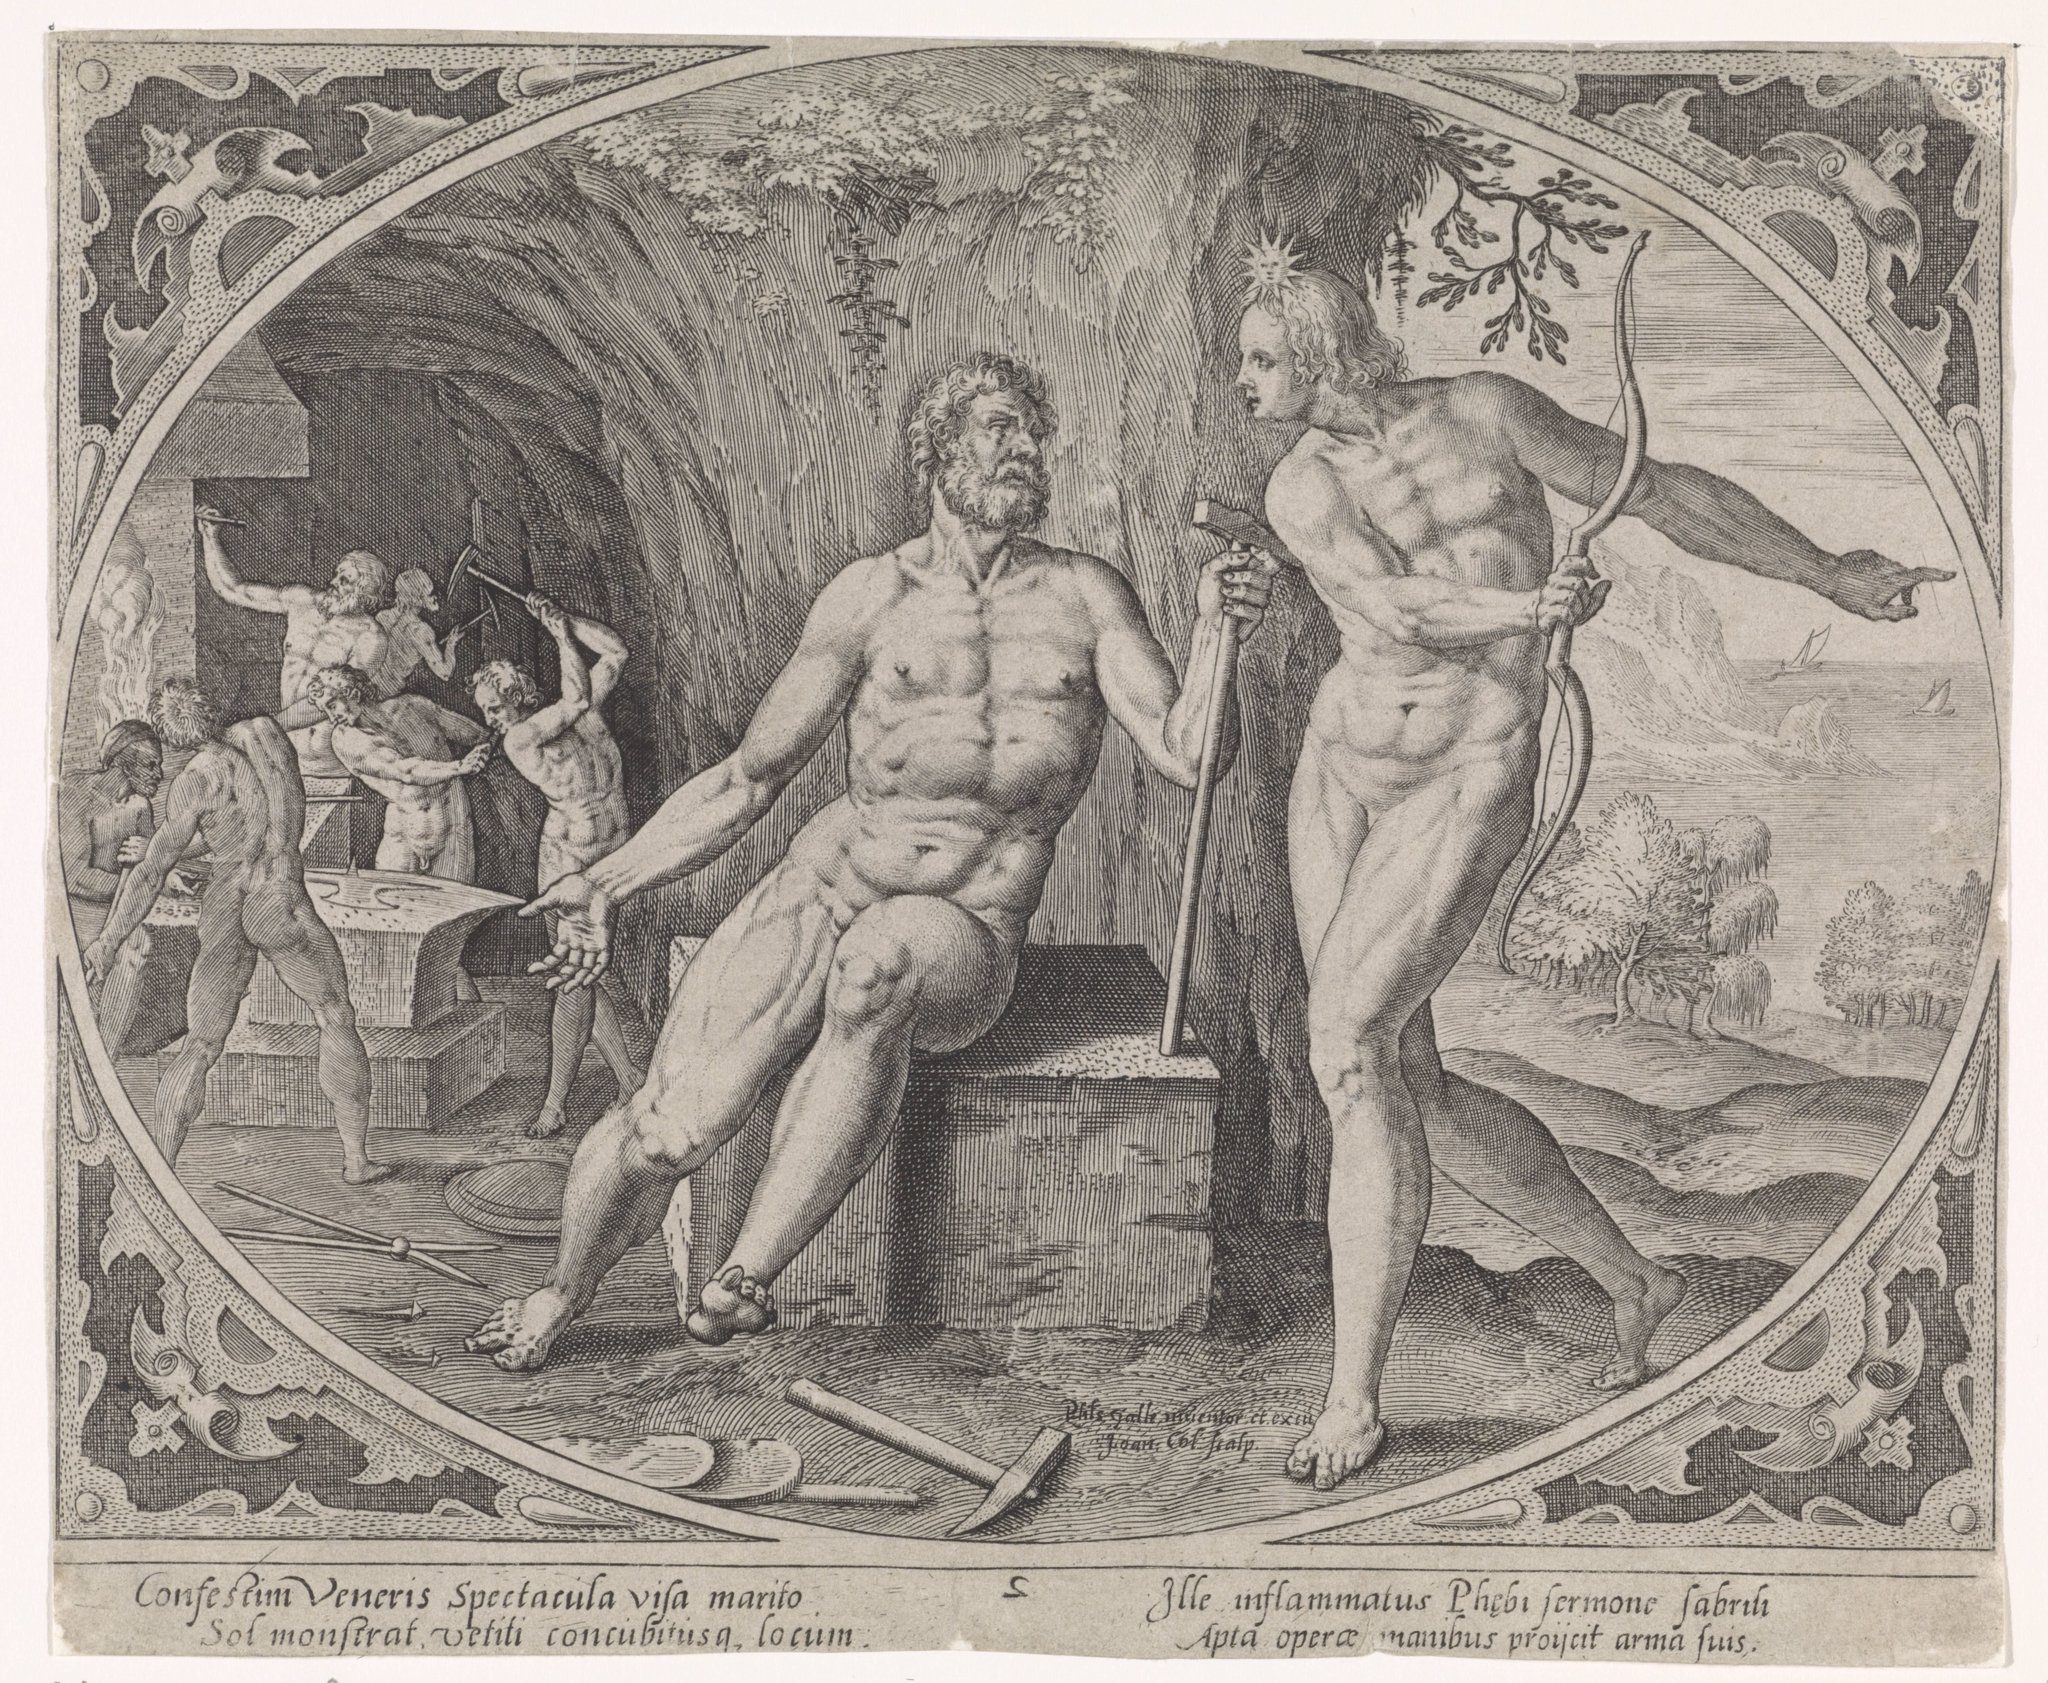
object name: print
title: Venus en Mars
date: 1576-1628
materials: paper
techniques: engraving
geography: antwerp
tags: apollo as sun-god, i.e. sol (helius), titan, apollo in vulcan's forge revealing venus' love-affair with mars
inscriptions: collector's mark: Lugt 2228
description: Ovale lijst met Phoebus en Vulcanus in de smidse. Phoebus vertelt de kreupele Vulcanus over het overspel van zijn vrouw. De prent heeft een Latijns onderschrift. De prent maakt deel uit van een serie over Venus en Mars